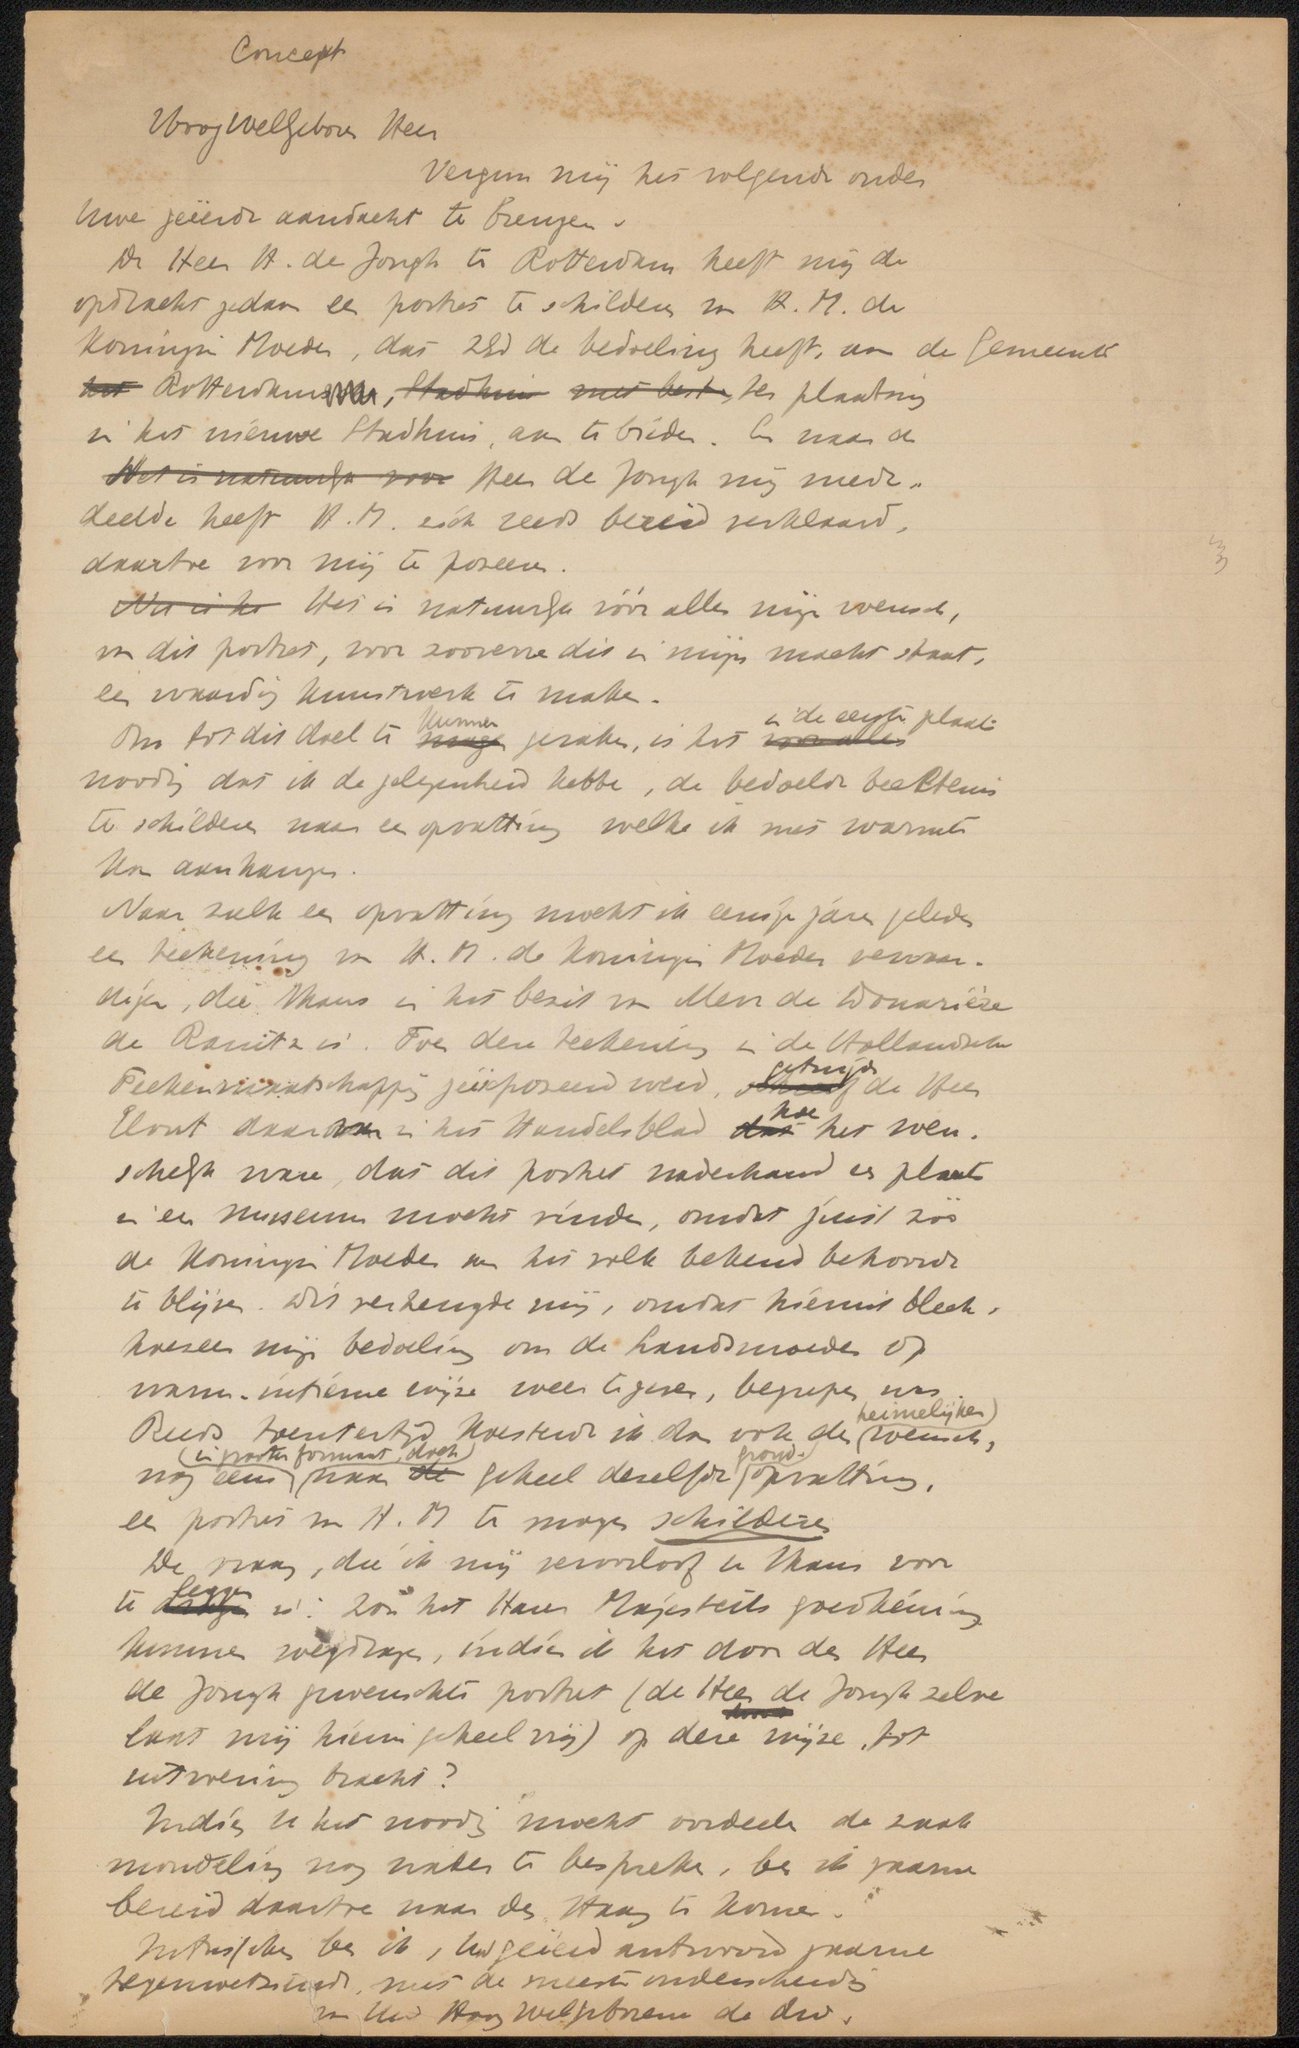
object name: letter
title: Conceptbrief aan onbekend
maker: jan veth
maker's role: designer, draughtsman, painter, print maker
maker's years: 1864-1925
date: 1918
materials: ink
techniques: pen, writing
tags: wilhelmina of the netherlands, newspaper, utrecht, cornelis karel elout, drawing, historical persons (portraits and scenes from the life), the hague, rotterdam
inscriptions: collector's mark: ‘RPK’